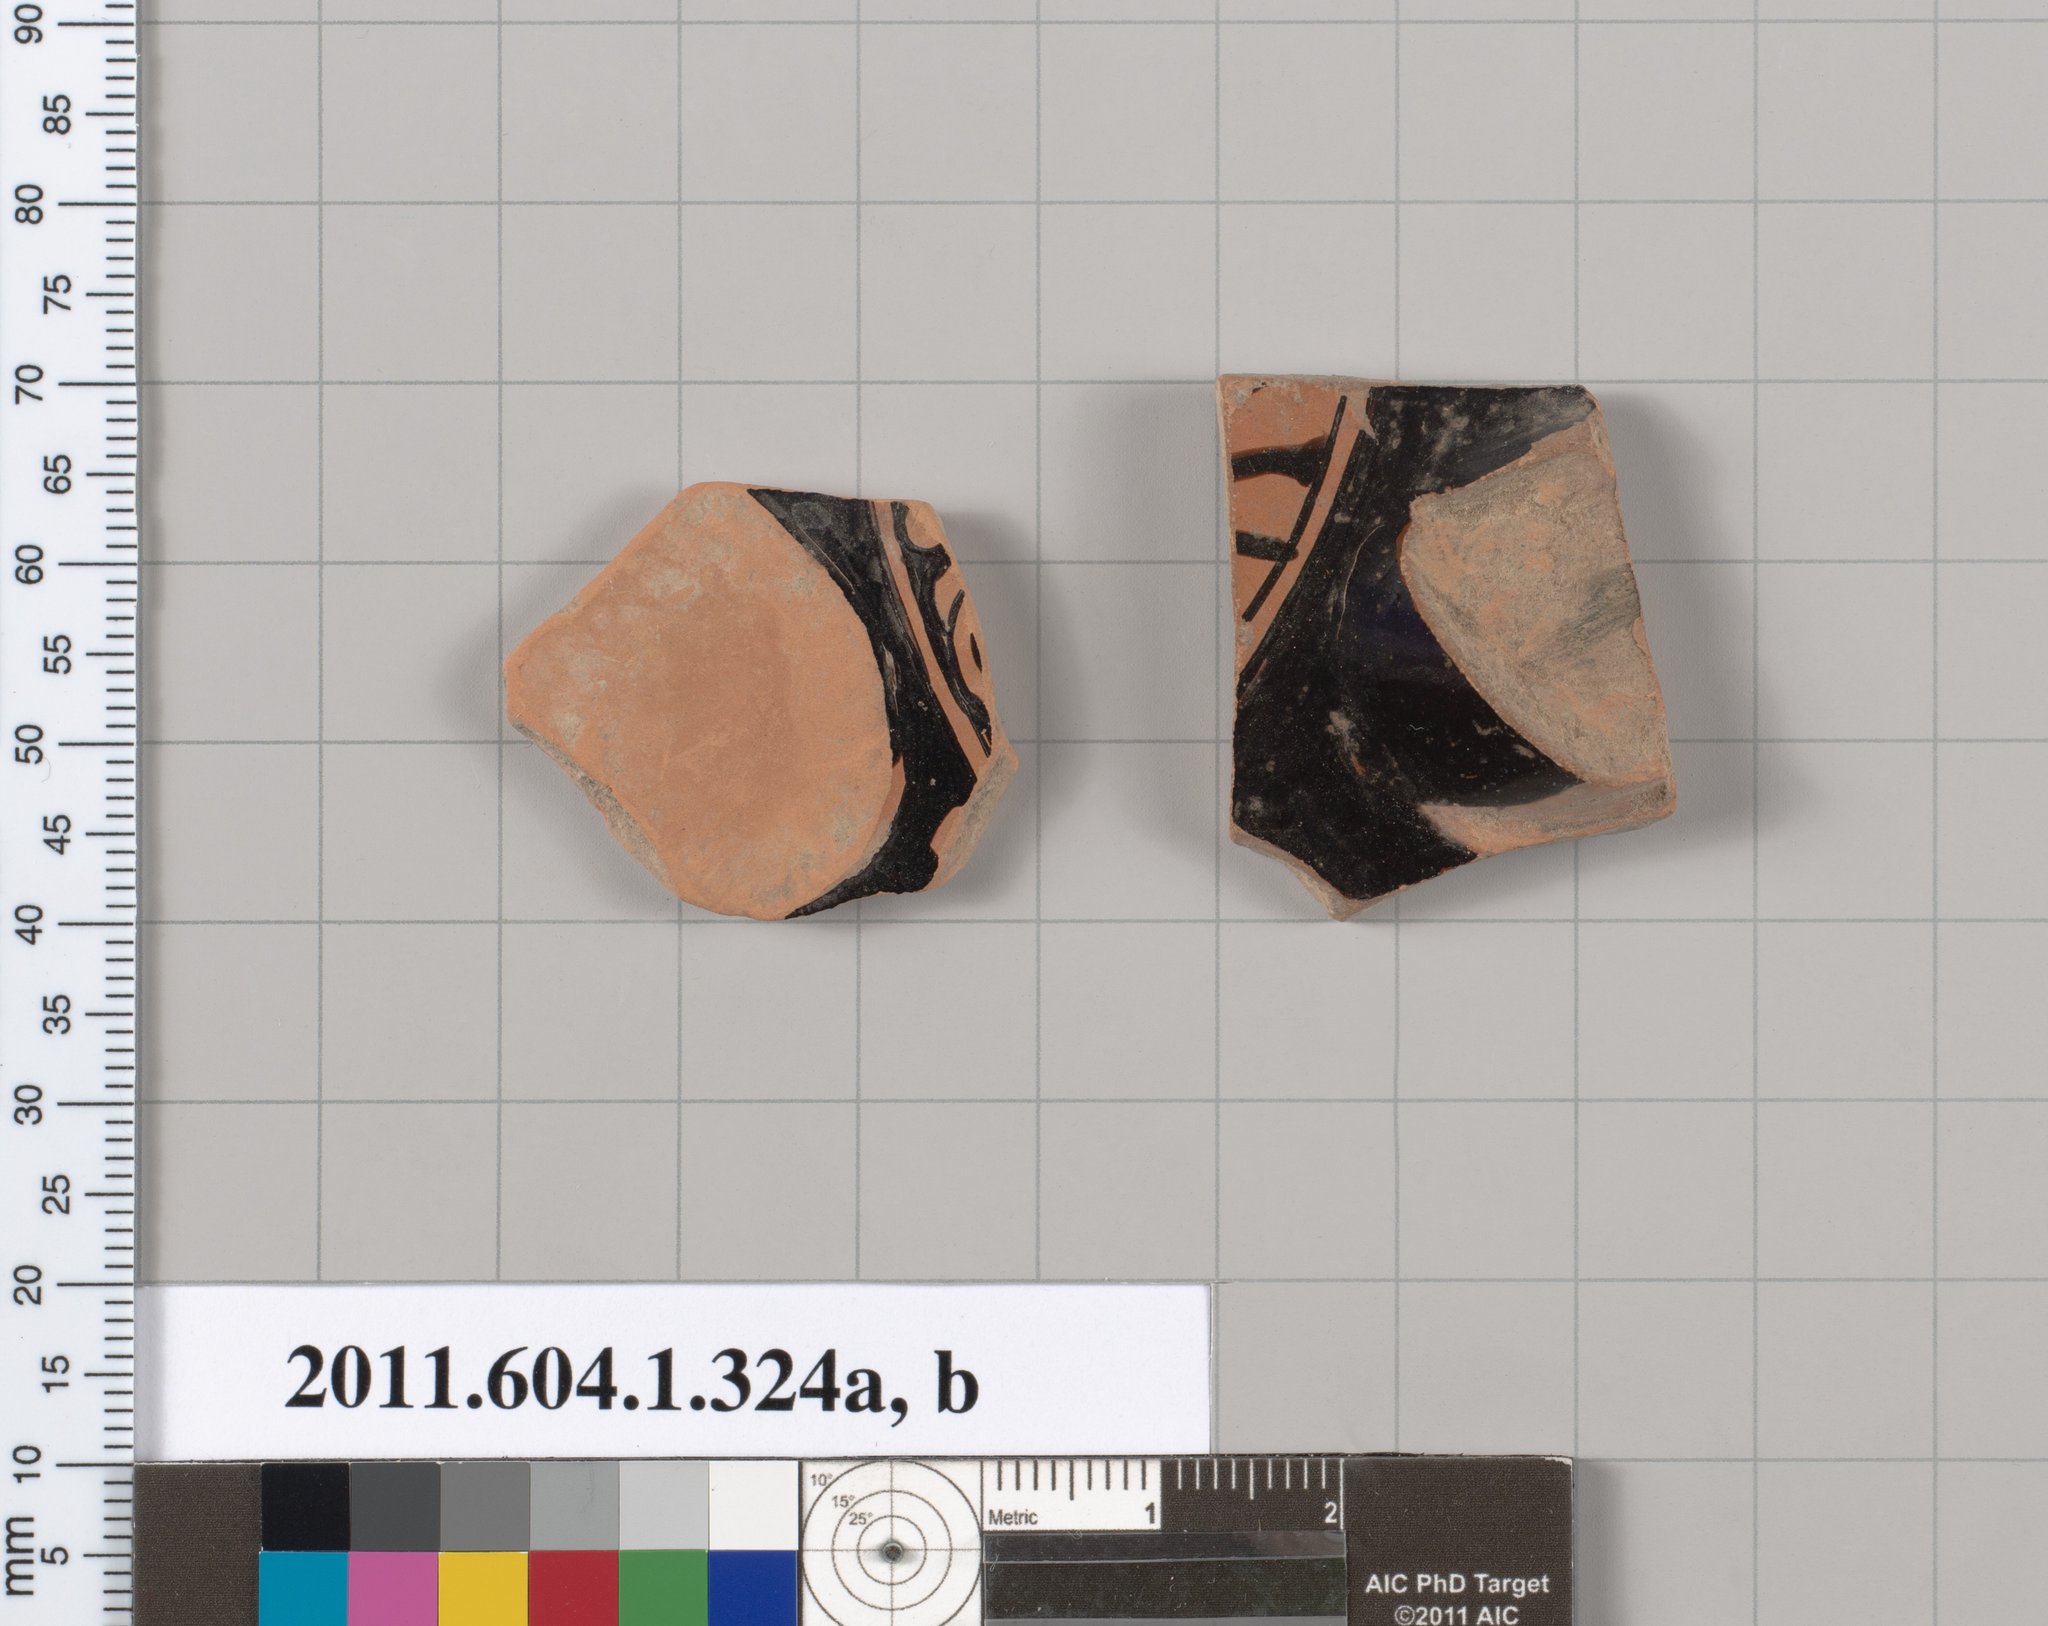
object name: kylix fragment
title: Terracotta fragments of kylikes (drinking cups)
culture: greek, attic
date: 475-451 BCE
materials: terracotta